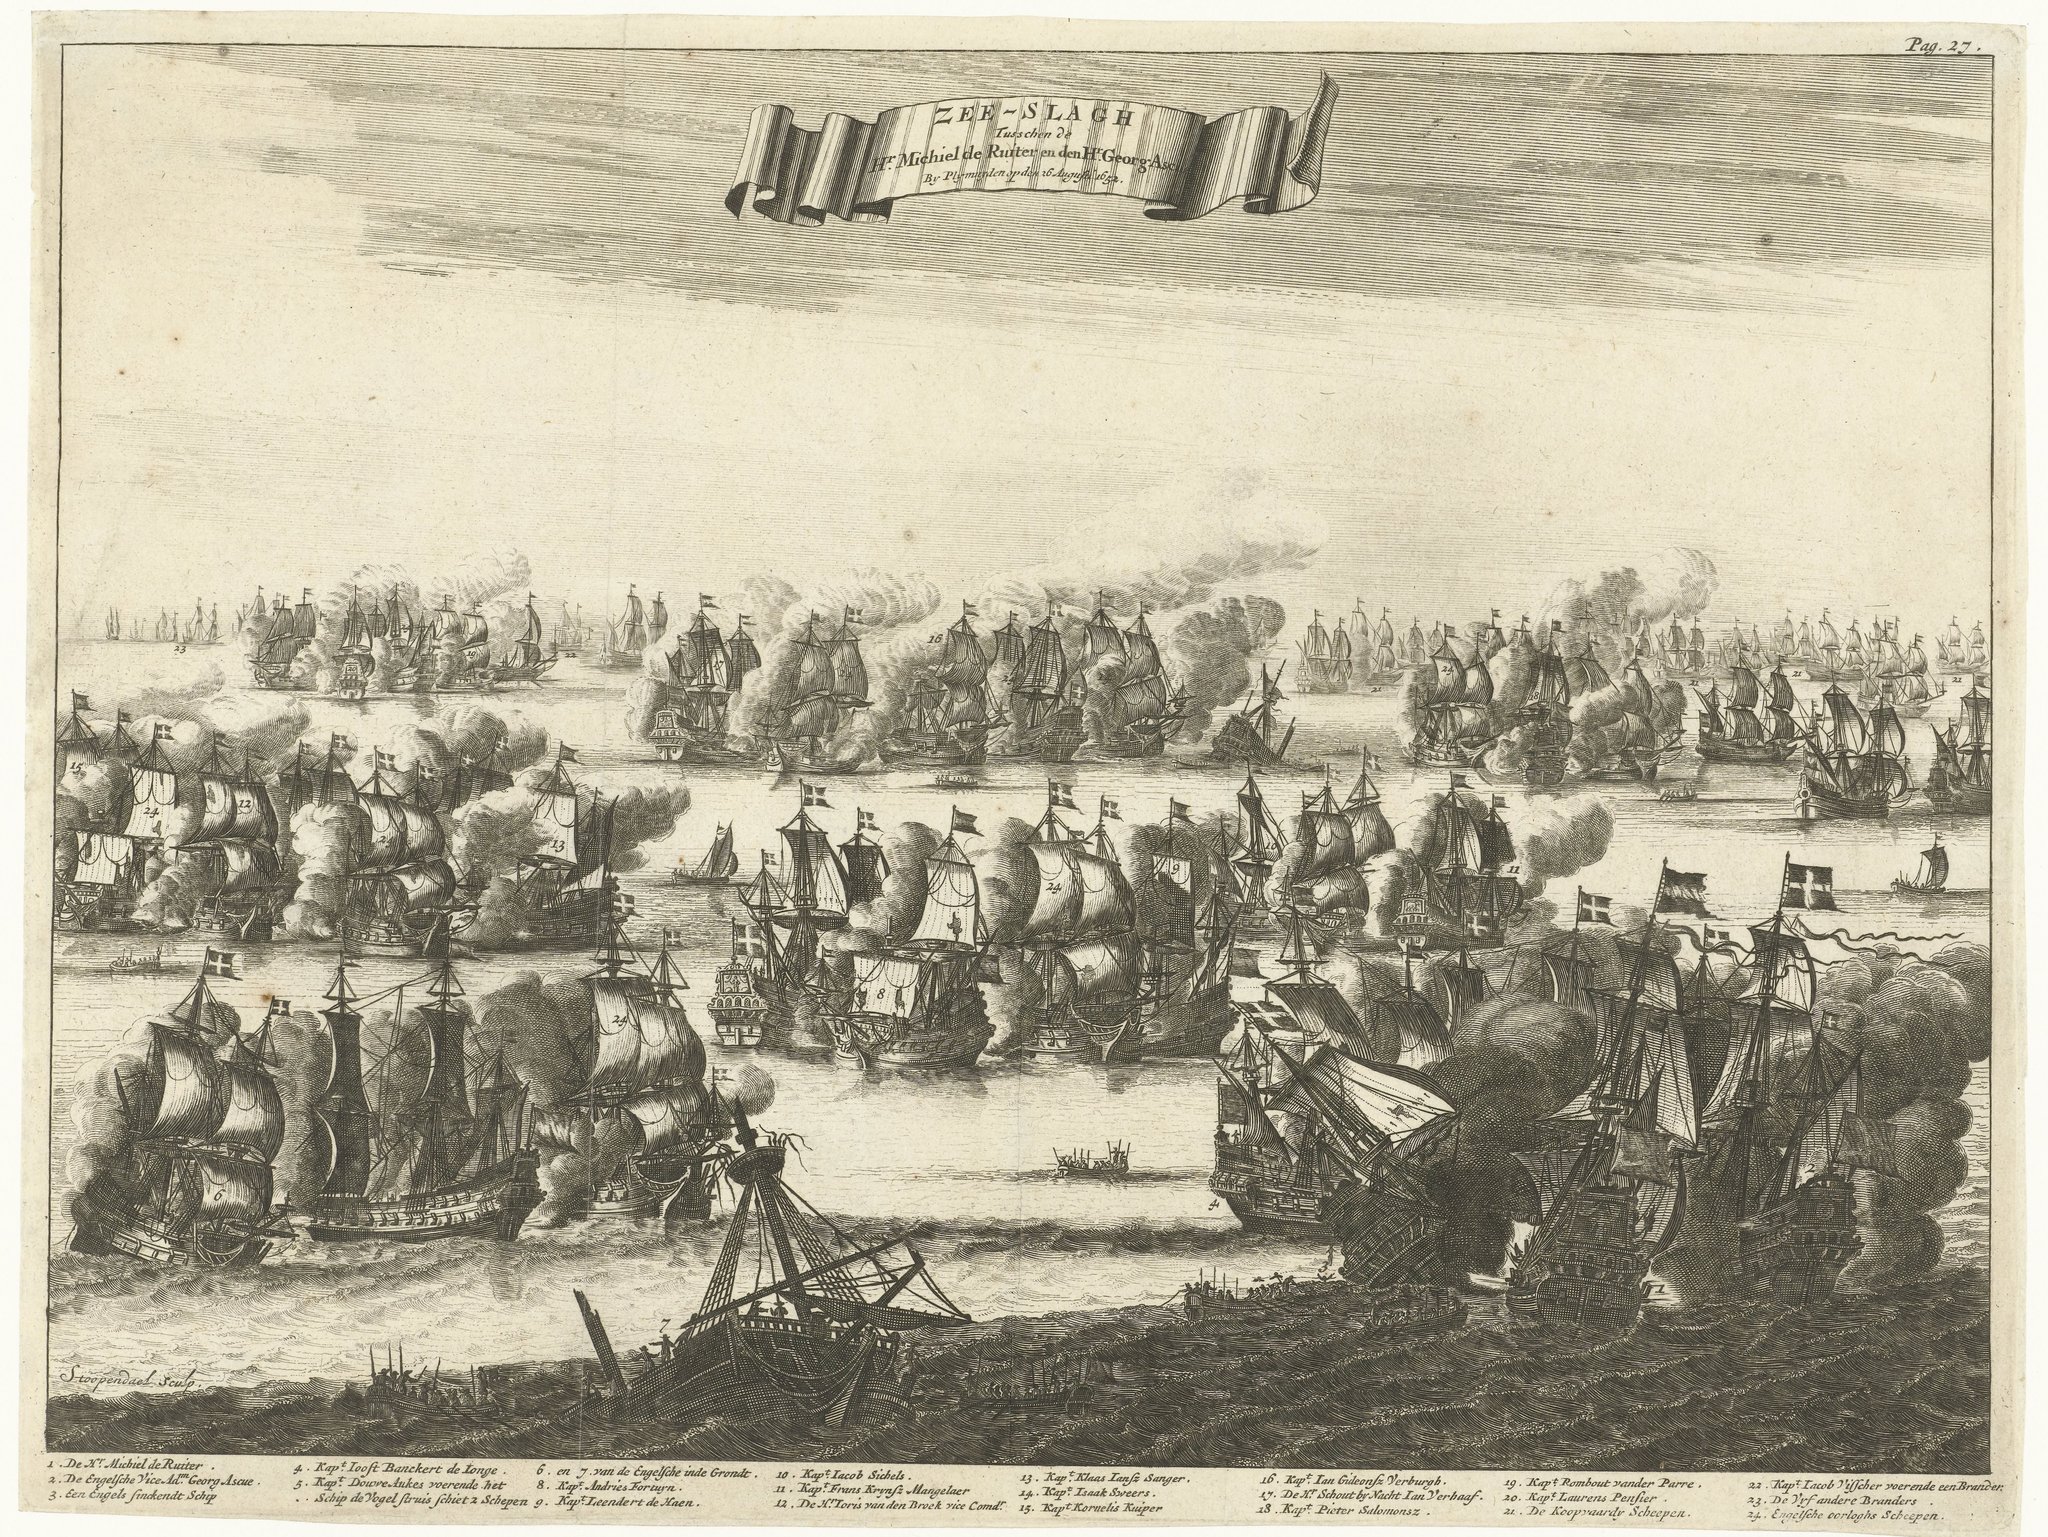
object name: print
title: Zee-Slagh Tusschen de Hr. Michiel de Ruiter en den Hr. Georg Ascue By Plymuyden op den 26 Augusti 1652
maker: bastiaen stopendael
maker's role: print maker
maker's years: 1636-1693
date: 1685-1687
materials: paper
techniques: etching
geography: northern netherlands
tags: flushing, michiel adriaenszoon de ruyter, battle (+ naval force)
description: Zeeslag bij Plymouth in de Eerste Engelse Oorlog tussen de Staatse vloot onder Michiel Adriaenszoon de Ruyter en de Engelse vloot onder George Ayscue, 26 augustus 1652. Bovenaan gemerkt: Pag. 27. In het onderschrift de legenda 1-24 in het Nederlands.